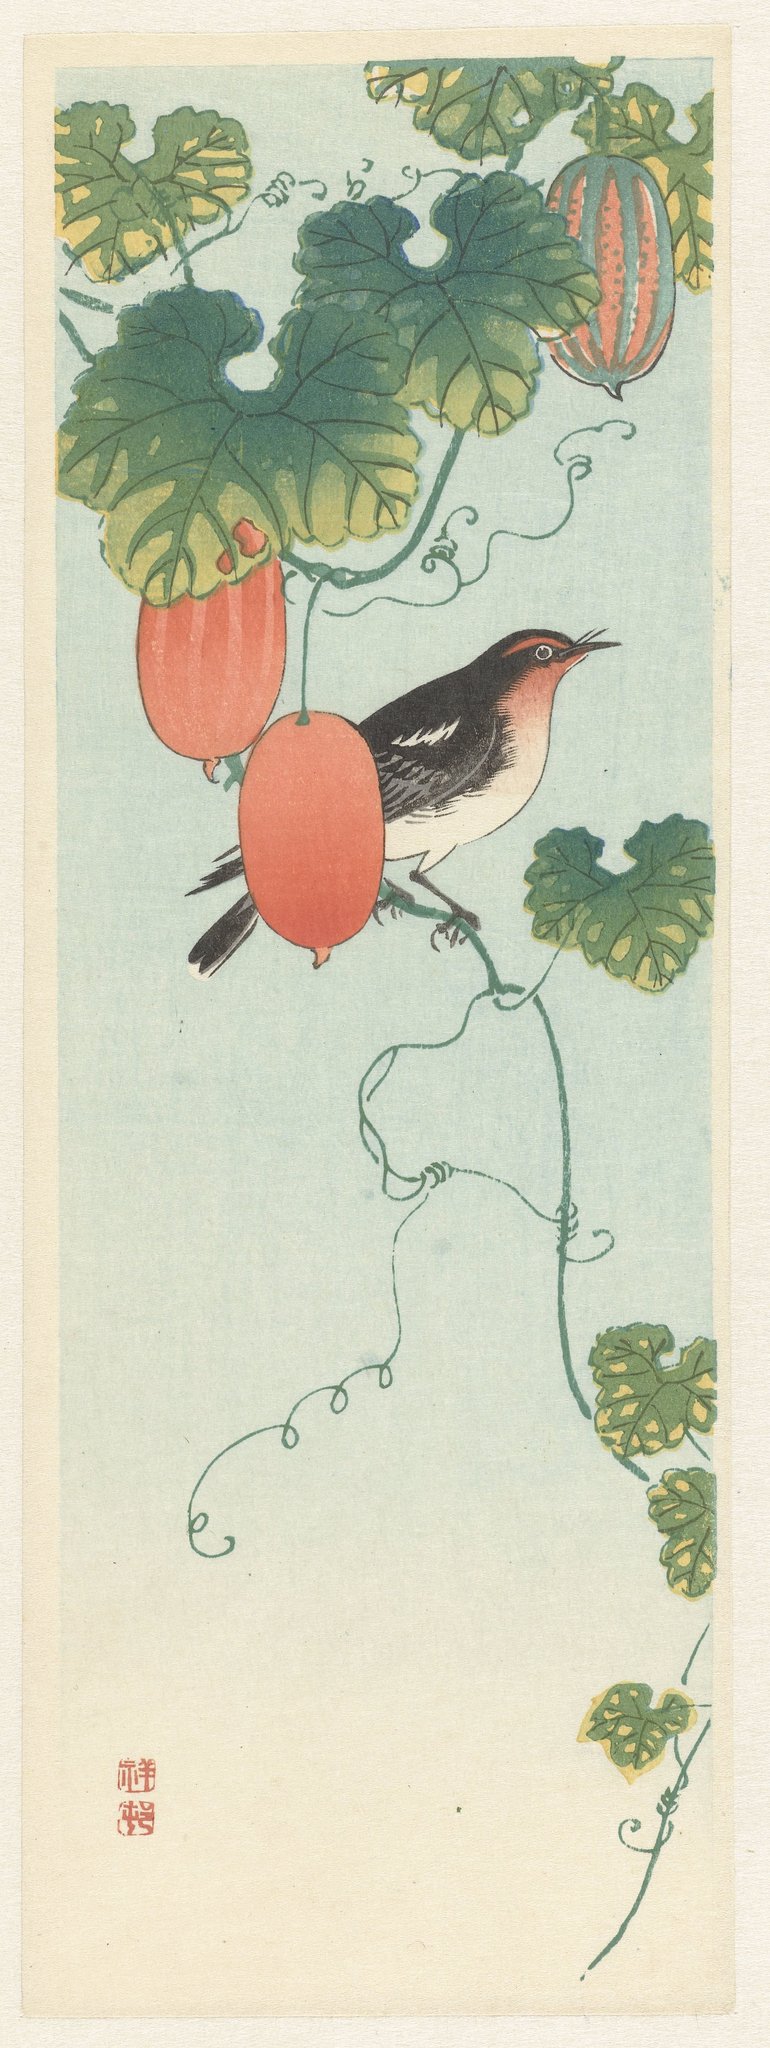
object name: print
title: Zangvogel in komkommerplant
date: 1925-1936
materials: paper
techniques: woodcut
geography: tokyo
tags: plants; vegetation, birds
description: Zwart met rood zangvogeltje op klimplant met oranje-groene vruchten